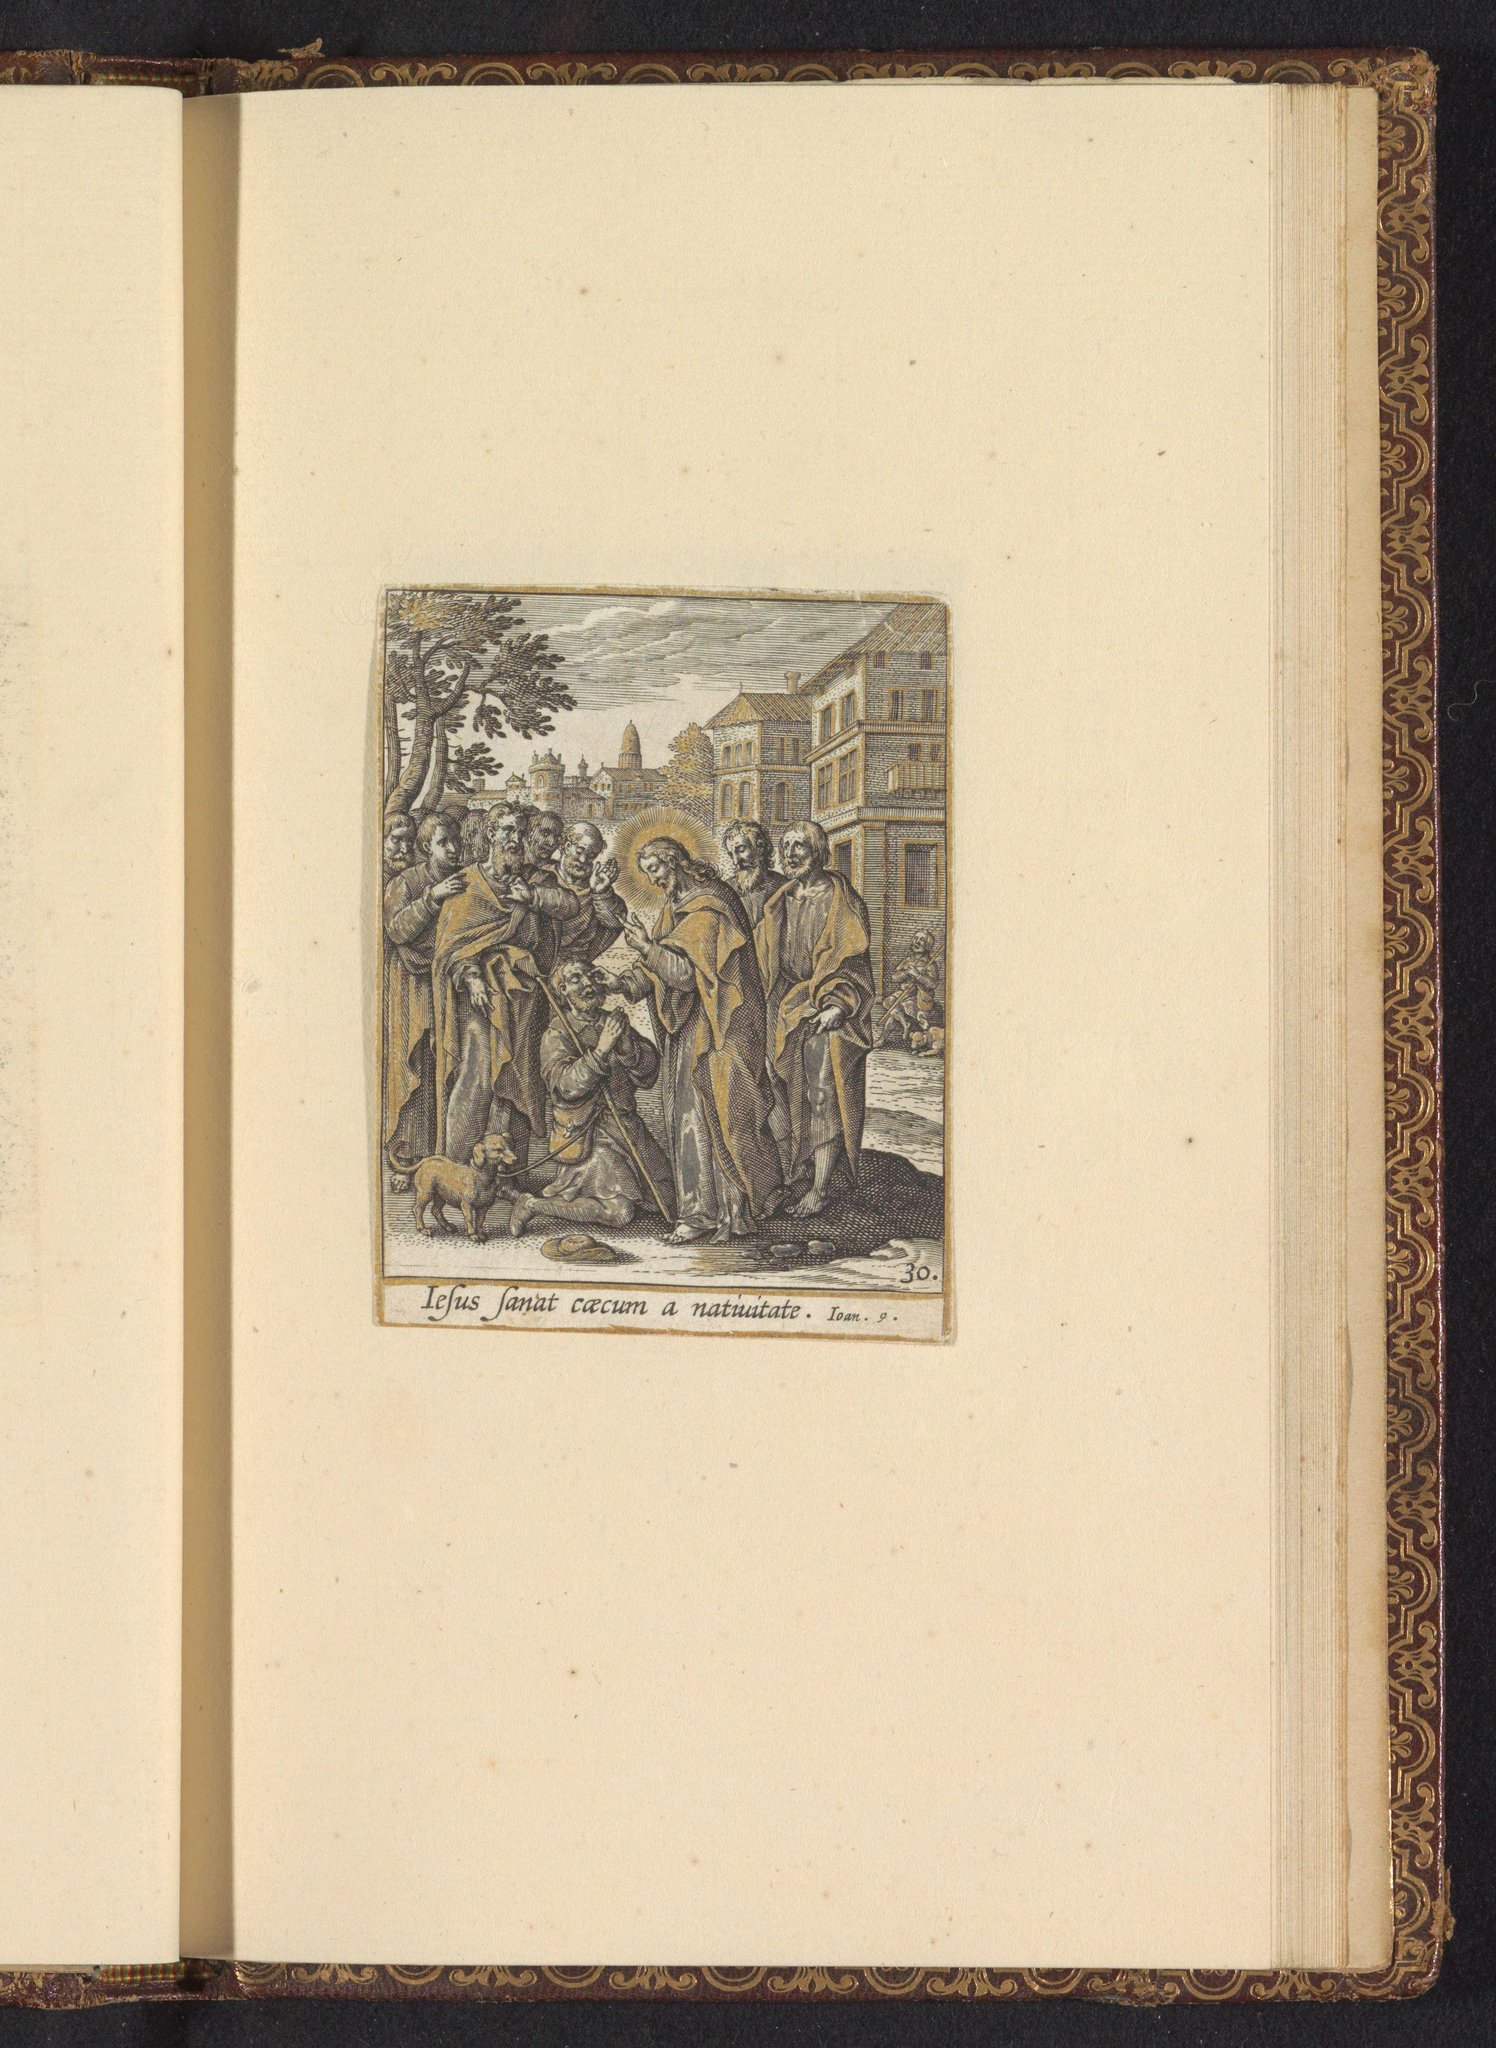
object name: print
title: Christus geneest de blindgeborene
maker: adriaen collaert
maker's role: draughtsman, print maker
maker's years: 1560-1618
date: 1580-1590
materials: gold, paper, silver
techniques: engraving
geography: antwerp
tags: healing of a man born blind: christ touches his eyes with an 'ointment' of dust and spittle (john 9)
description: Christus geneest een man die blind geboren is. Onderdeel van de prentserie over het leven van Christus: Vita Iesu Salvatoris varijs iconibus ab Adriano Collaert expressa. In prentalbum met twee reeksen van respectievelijk 34 en 25 gravures met scènes uit het leven en het lijdensverhaal van Christus.